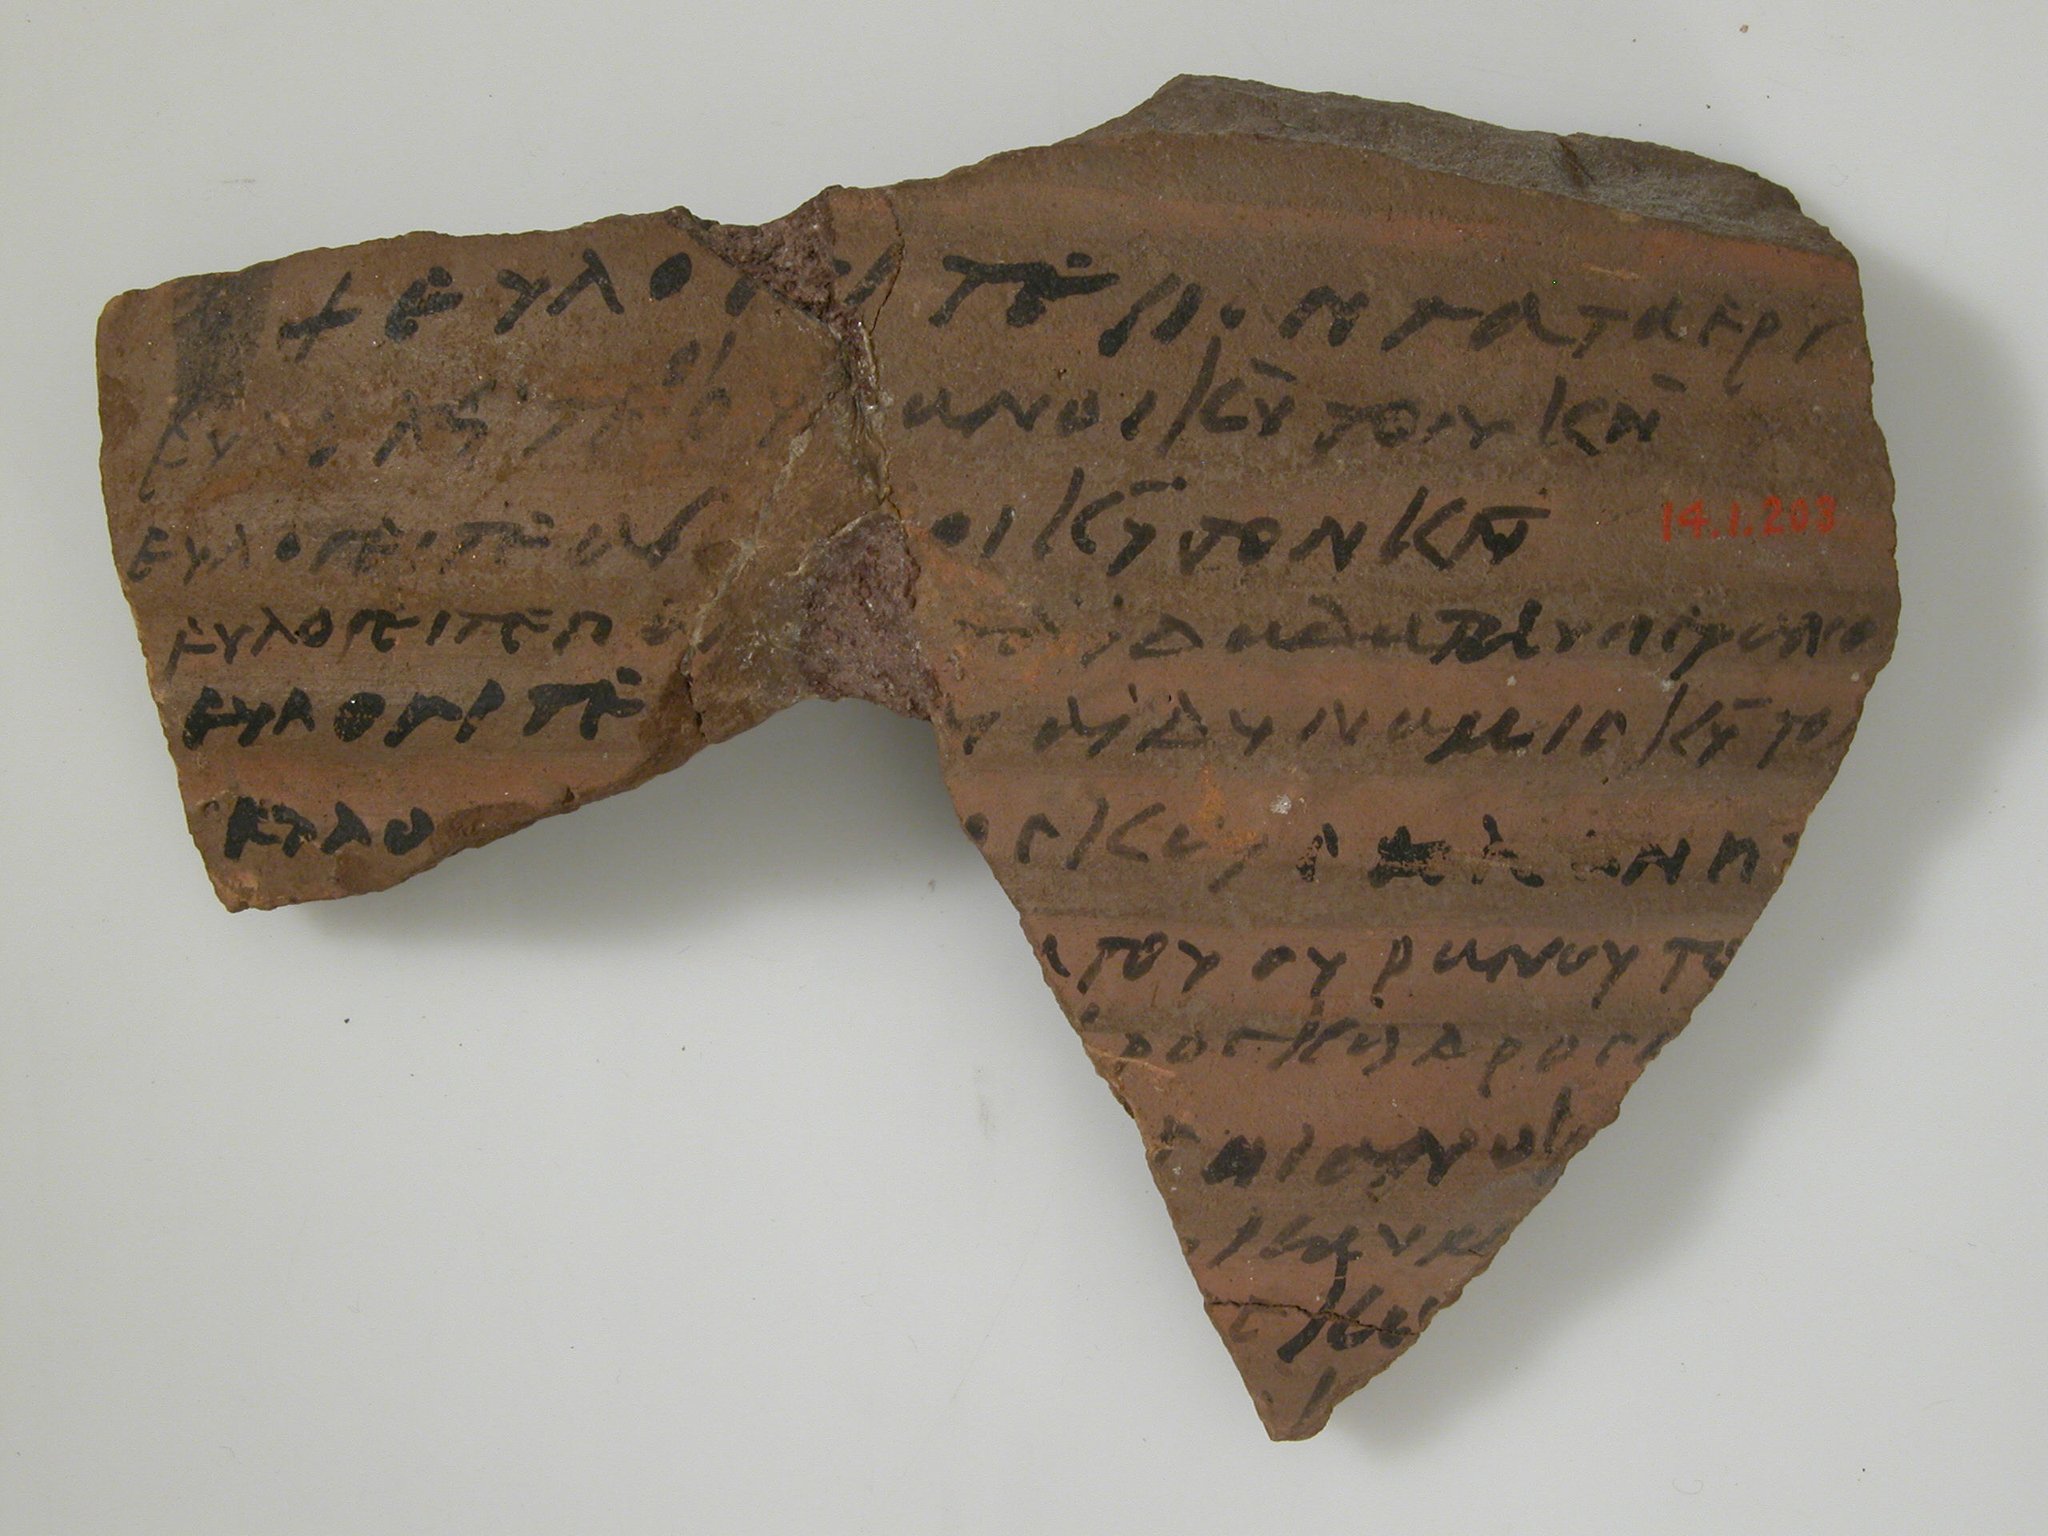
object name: ostrakon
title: Ostrakon with Biblical Text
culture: coptic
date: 580-640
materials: ink, pottery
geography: egypt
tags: greek